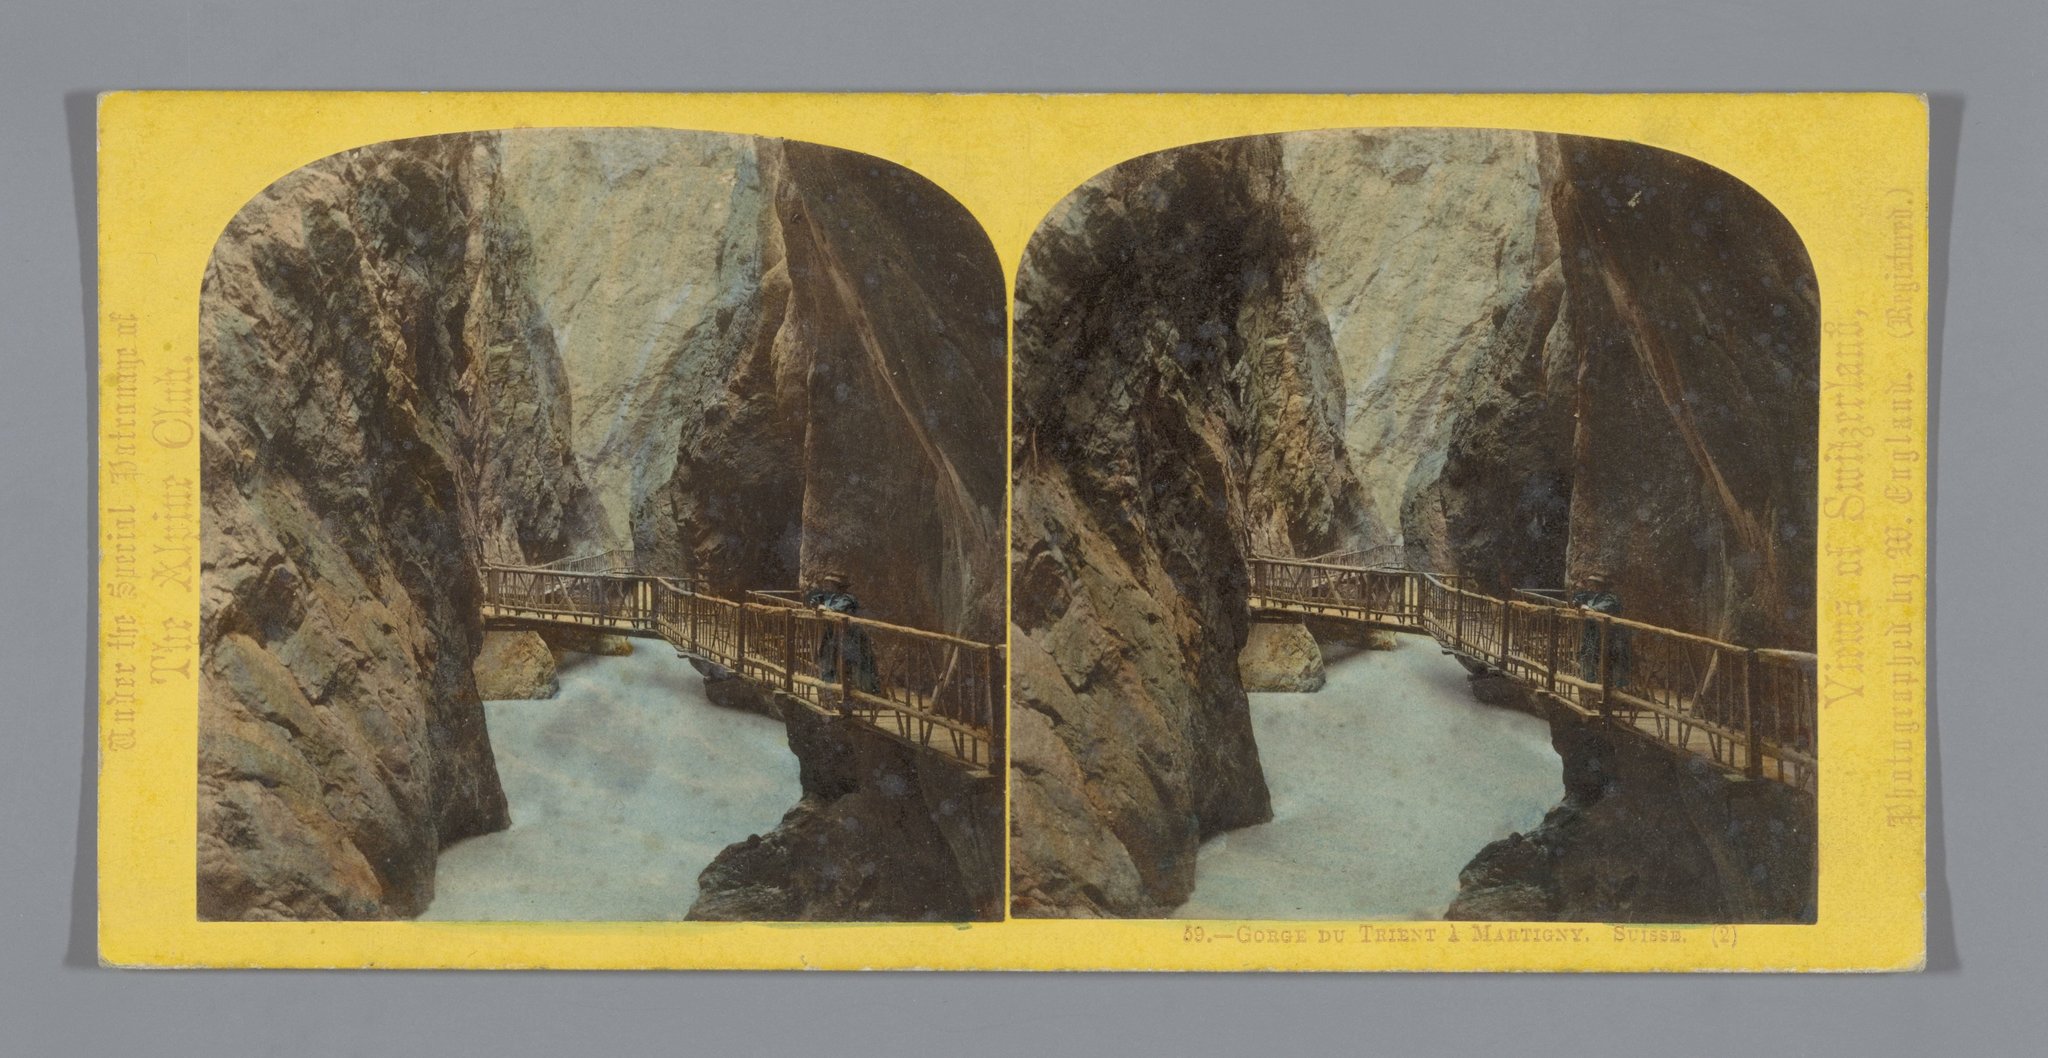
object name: stereograph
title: Gorge du Trient à Martigny. Suisse. (2)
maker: william england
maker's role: fotograaf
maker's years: 1816-1896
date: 1850-1880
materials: cardboard, photographic support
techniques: albumen print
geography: wallis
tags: ravine, chasm, abyss, canyon, bridge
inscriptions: number: ‘59.’, inscription: ‘Views of Switzerland, photographed by W. England. (Registered) Under the Special Patronage of the Alpine Club.’